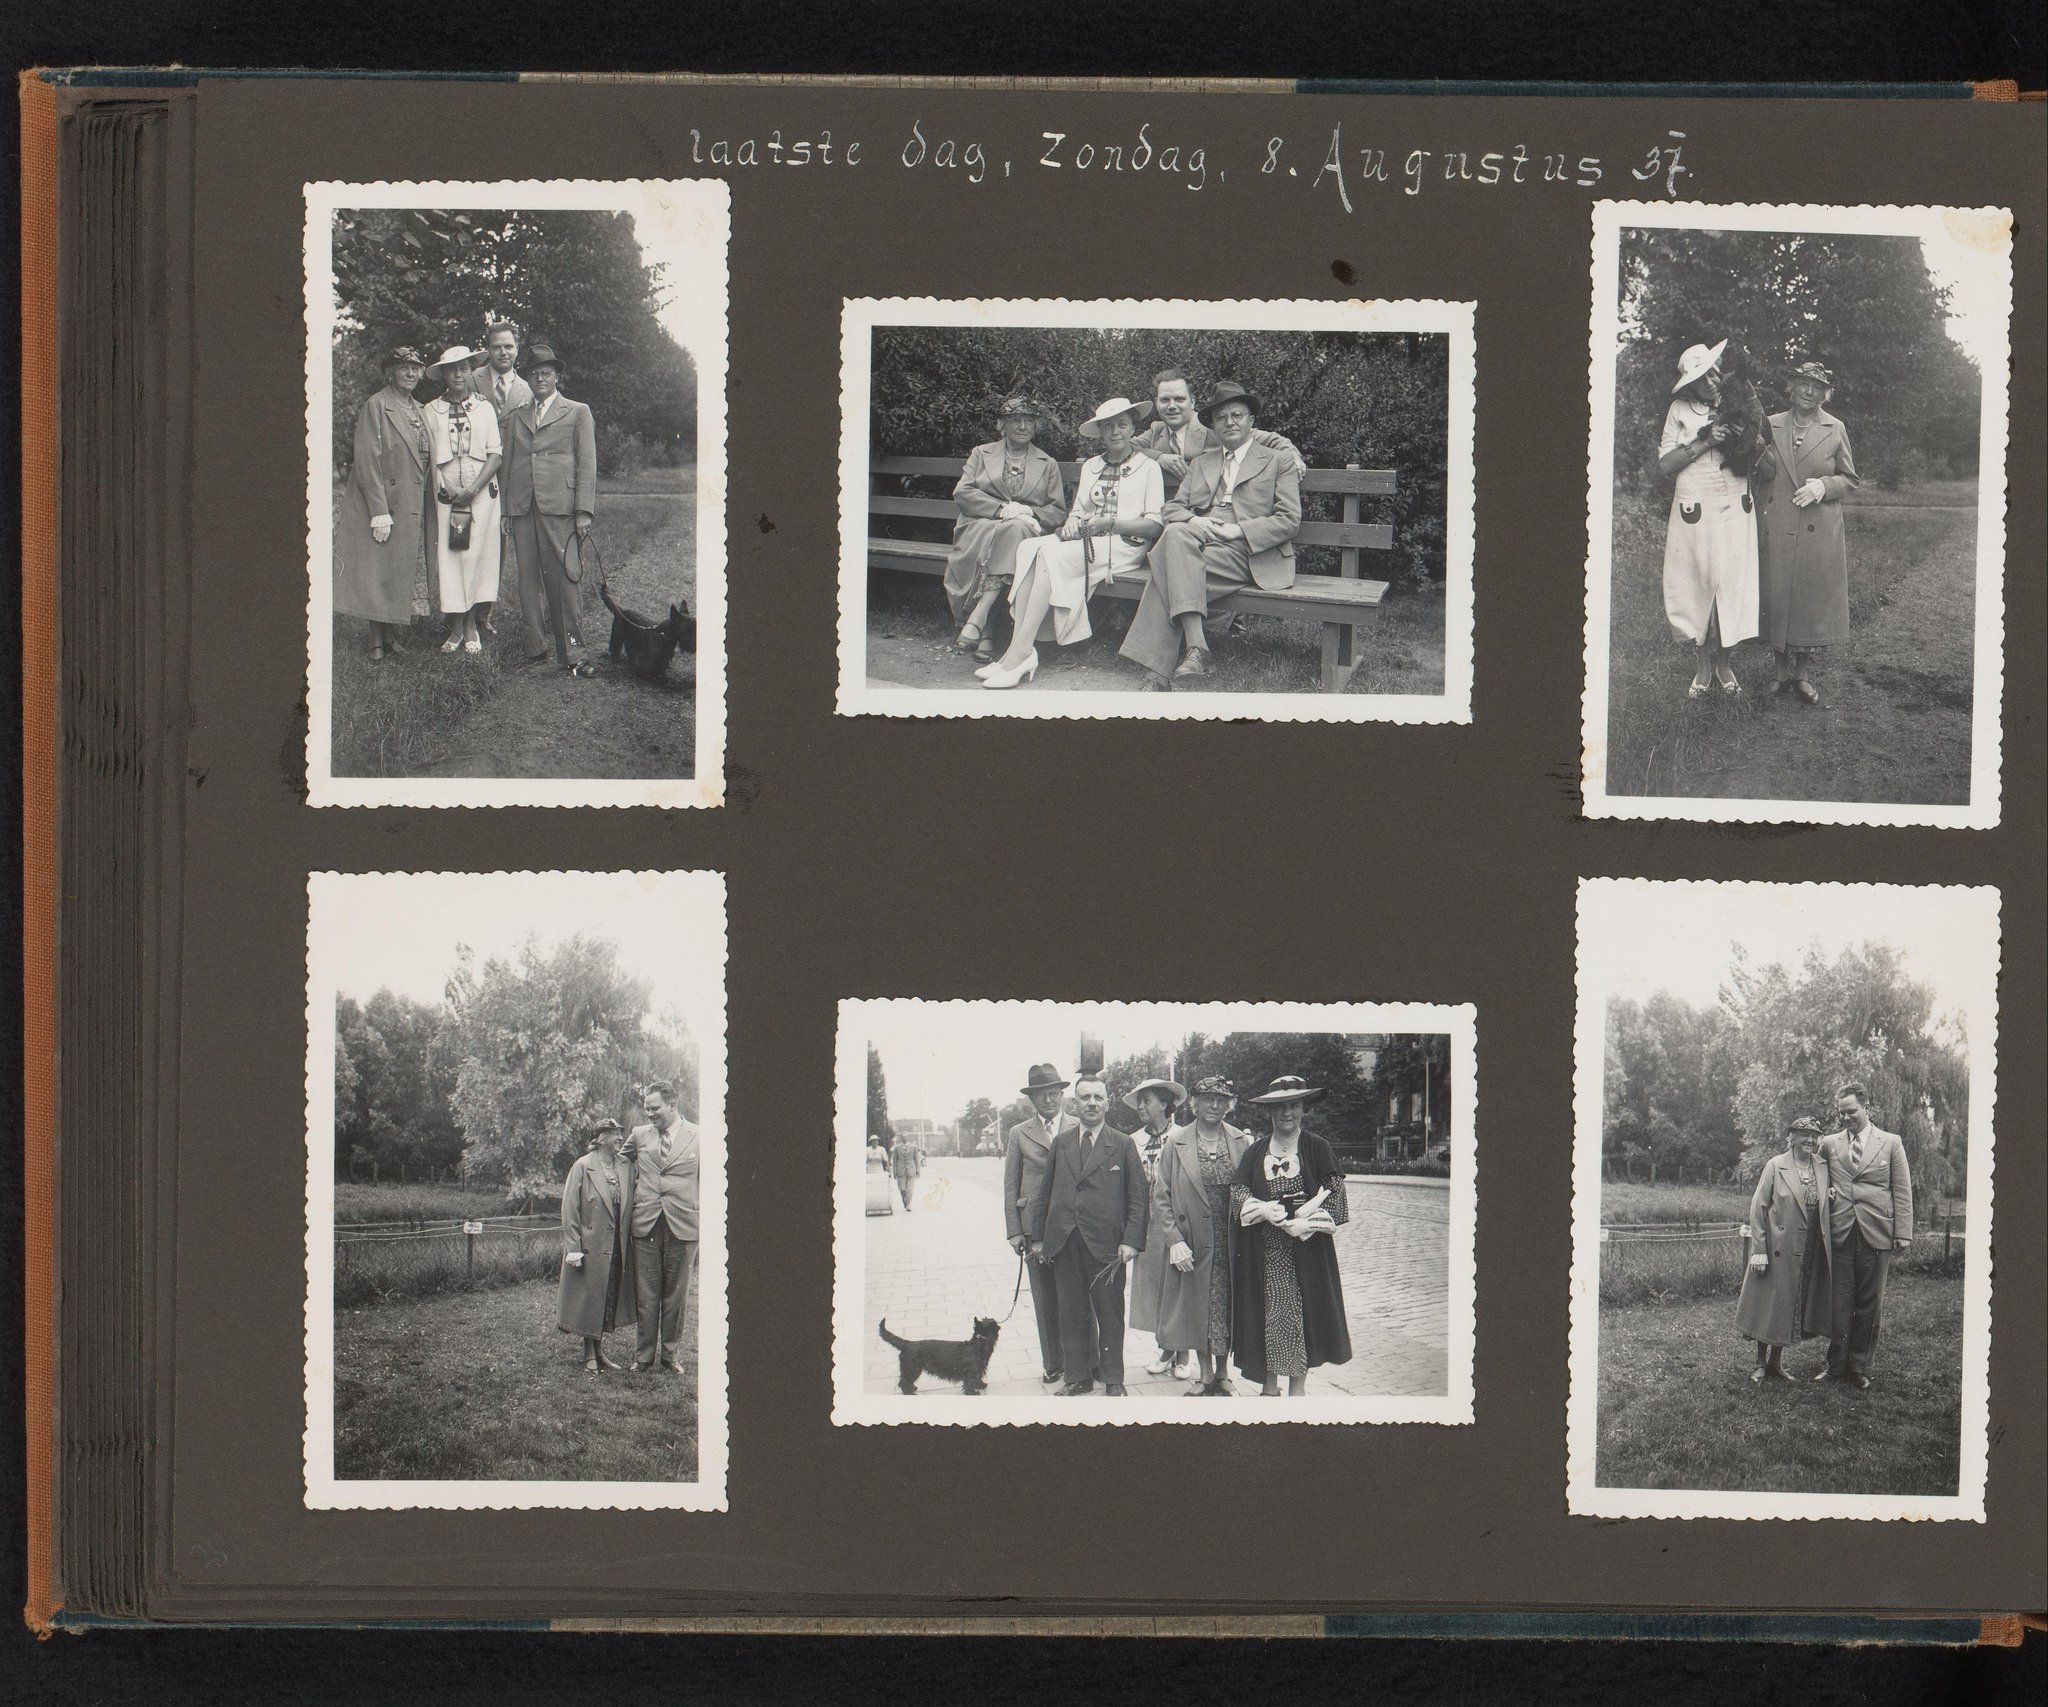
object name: photograph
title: Groepsportretten van Herman Besselaar en Berti Hoppe met haar ouders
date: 1937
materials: cardboard, paper, photographic support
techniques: gelatin silver print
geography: rotterdam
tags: herman besselaar, berti hoppe, walking the dog, street (+ city(-scape) with figures, staffage), anonymous historical persons portrayed in a group, in a group-portrait, rotterdam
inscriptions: date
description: Zes foto's gemaakt tijdens de laatste dag van het bezoek van de ouders van Berti Hoppe. Deze pagina maakt deel uit van een album.